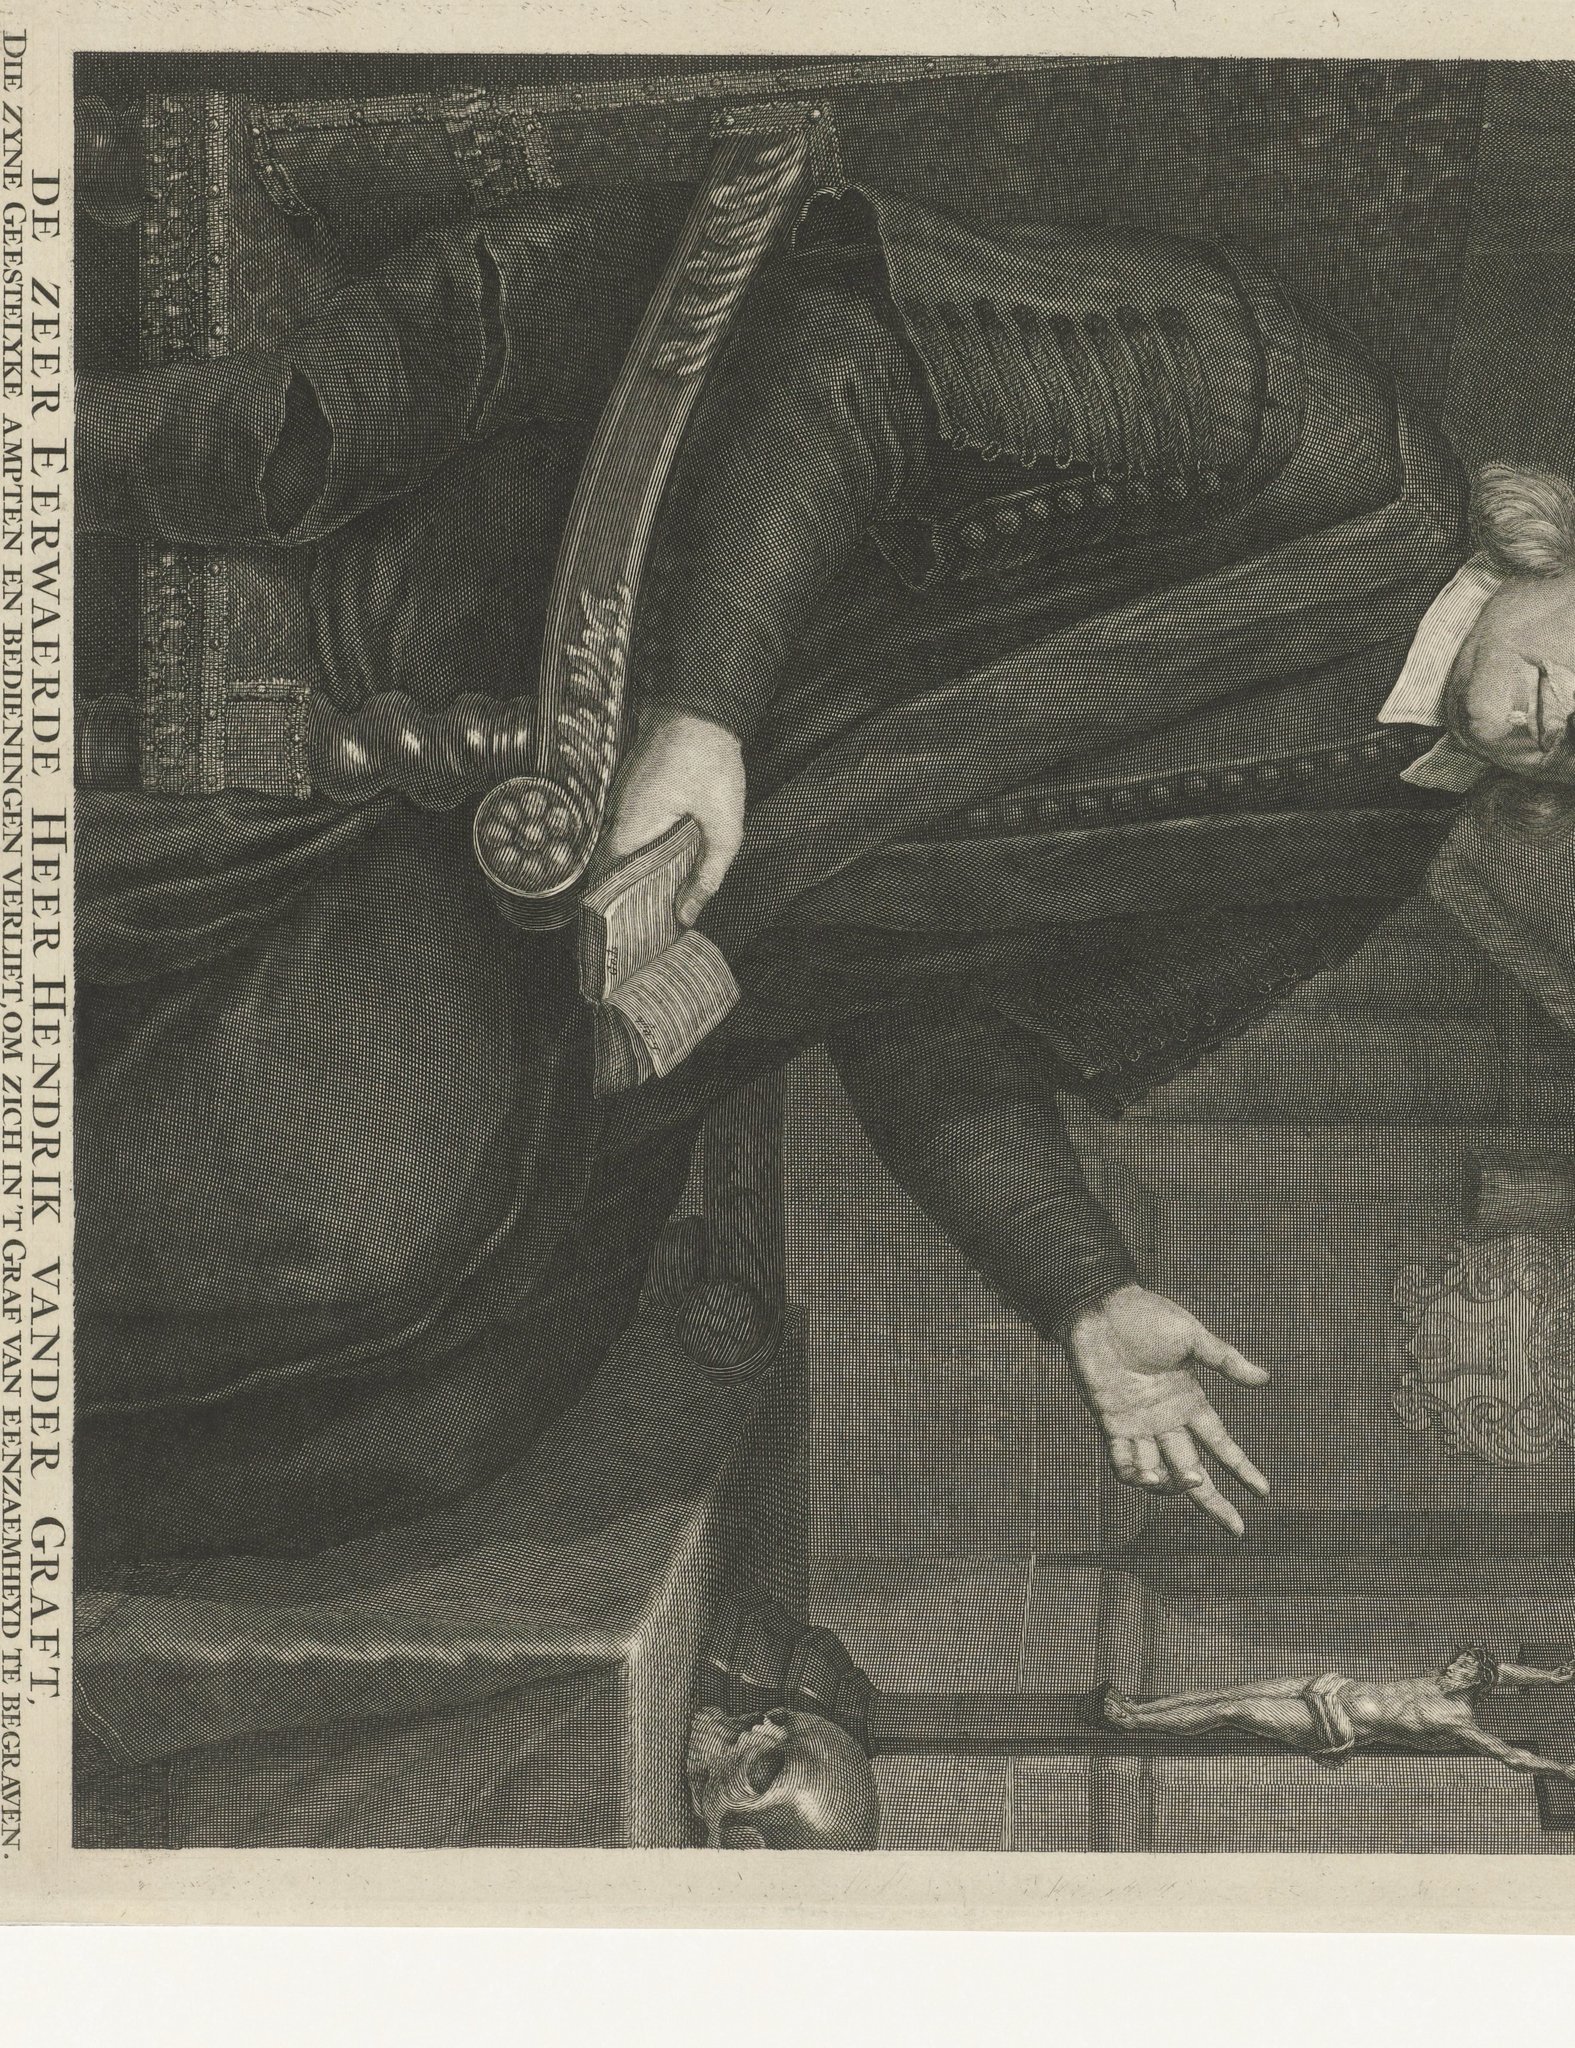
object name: print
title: Portret van Hendrik van der Graft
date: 1694-1696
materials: paper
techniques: engraving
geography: netherlands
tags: hendrik van der graft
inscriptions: collector's mark: Lugt 2228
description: Portret van Hendrik van der Graft, pastoor, zittend in een stoel en wijzend op een crucifix. Onderaan in de marge twee zesregelige verzen in het Nederlands.